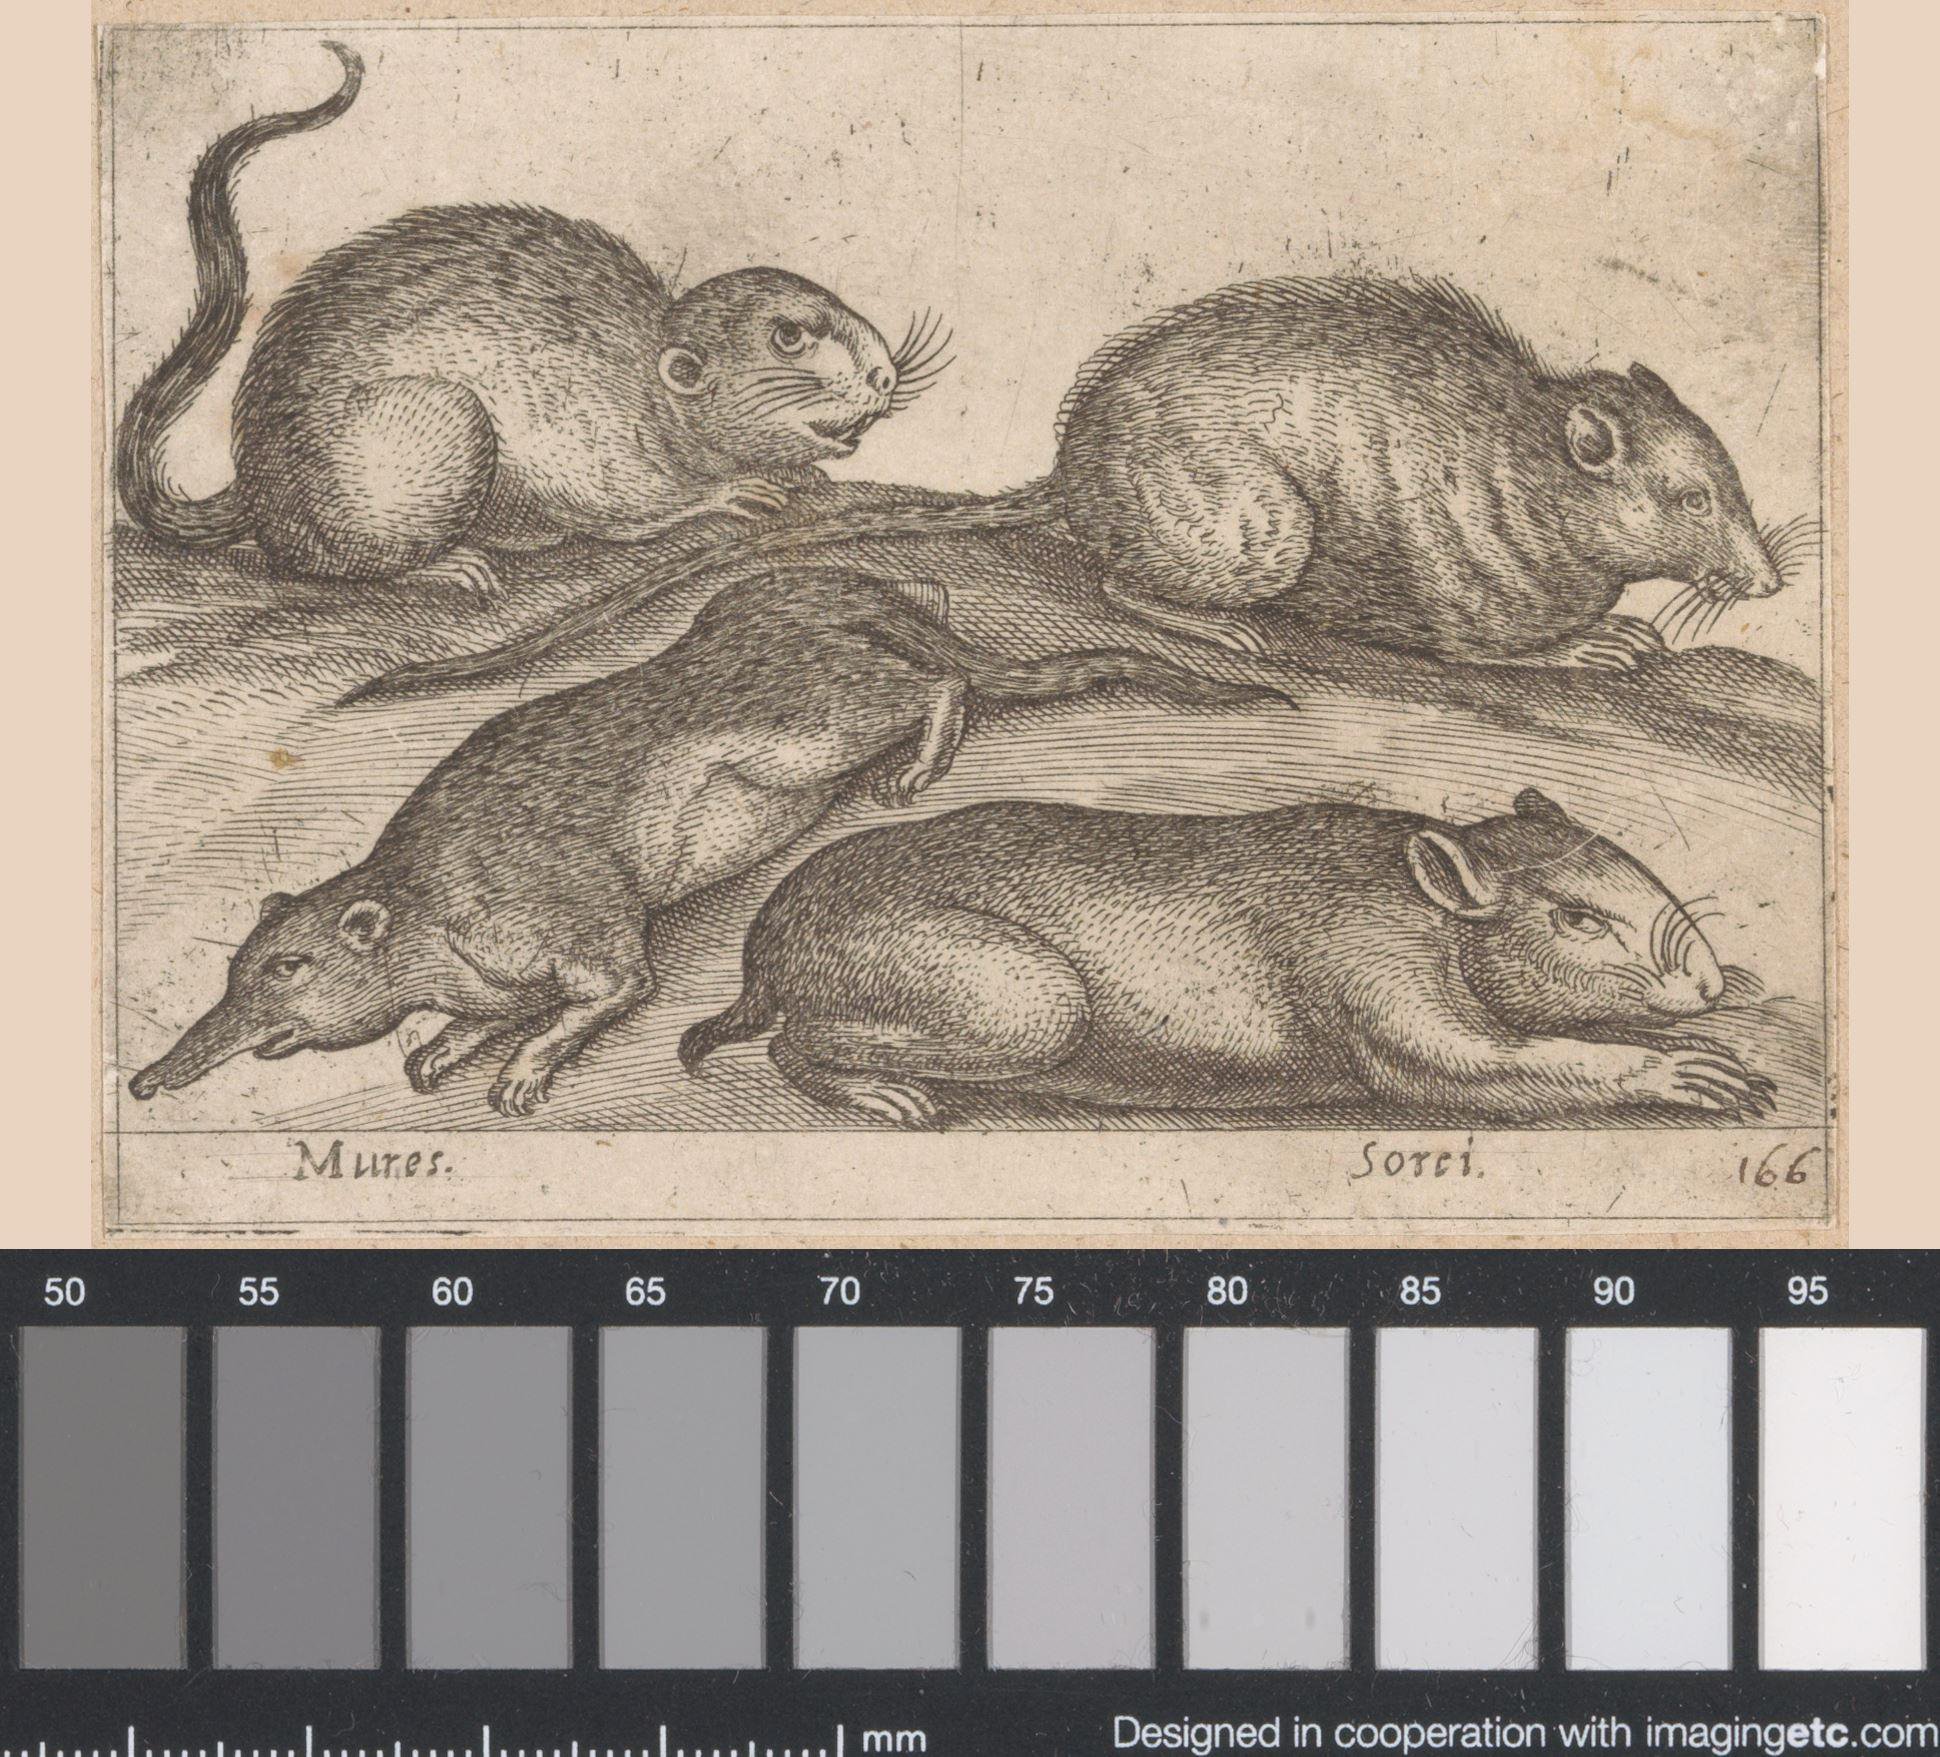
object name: print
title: Vier verschillende soorten ratten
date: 1565-1630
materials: paper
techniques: etching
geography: italy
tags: rodents: rat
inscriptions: collector's mark: Lugt 11, number: ‘166’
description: Deze prent maakt deel uit van een reeks prenten van dieren door Antonio Tempesta. Bekend is dat een tweede staat (met nummering) van deze serie is uitgegeven door Giovanni Giacomo de' Rossi in 1650. Onbekend is wie de eerste staat heeft uitgegeven en wanneer.